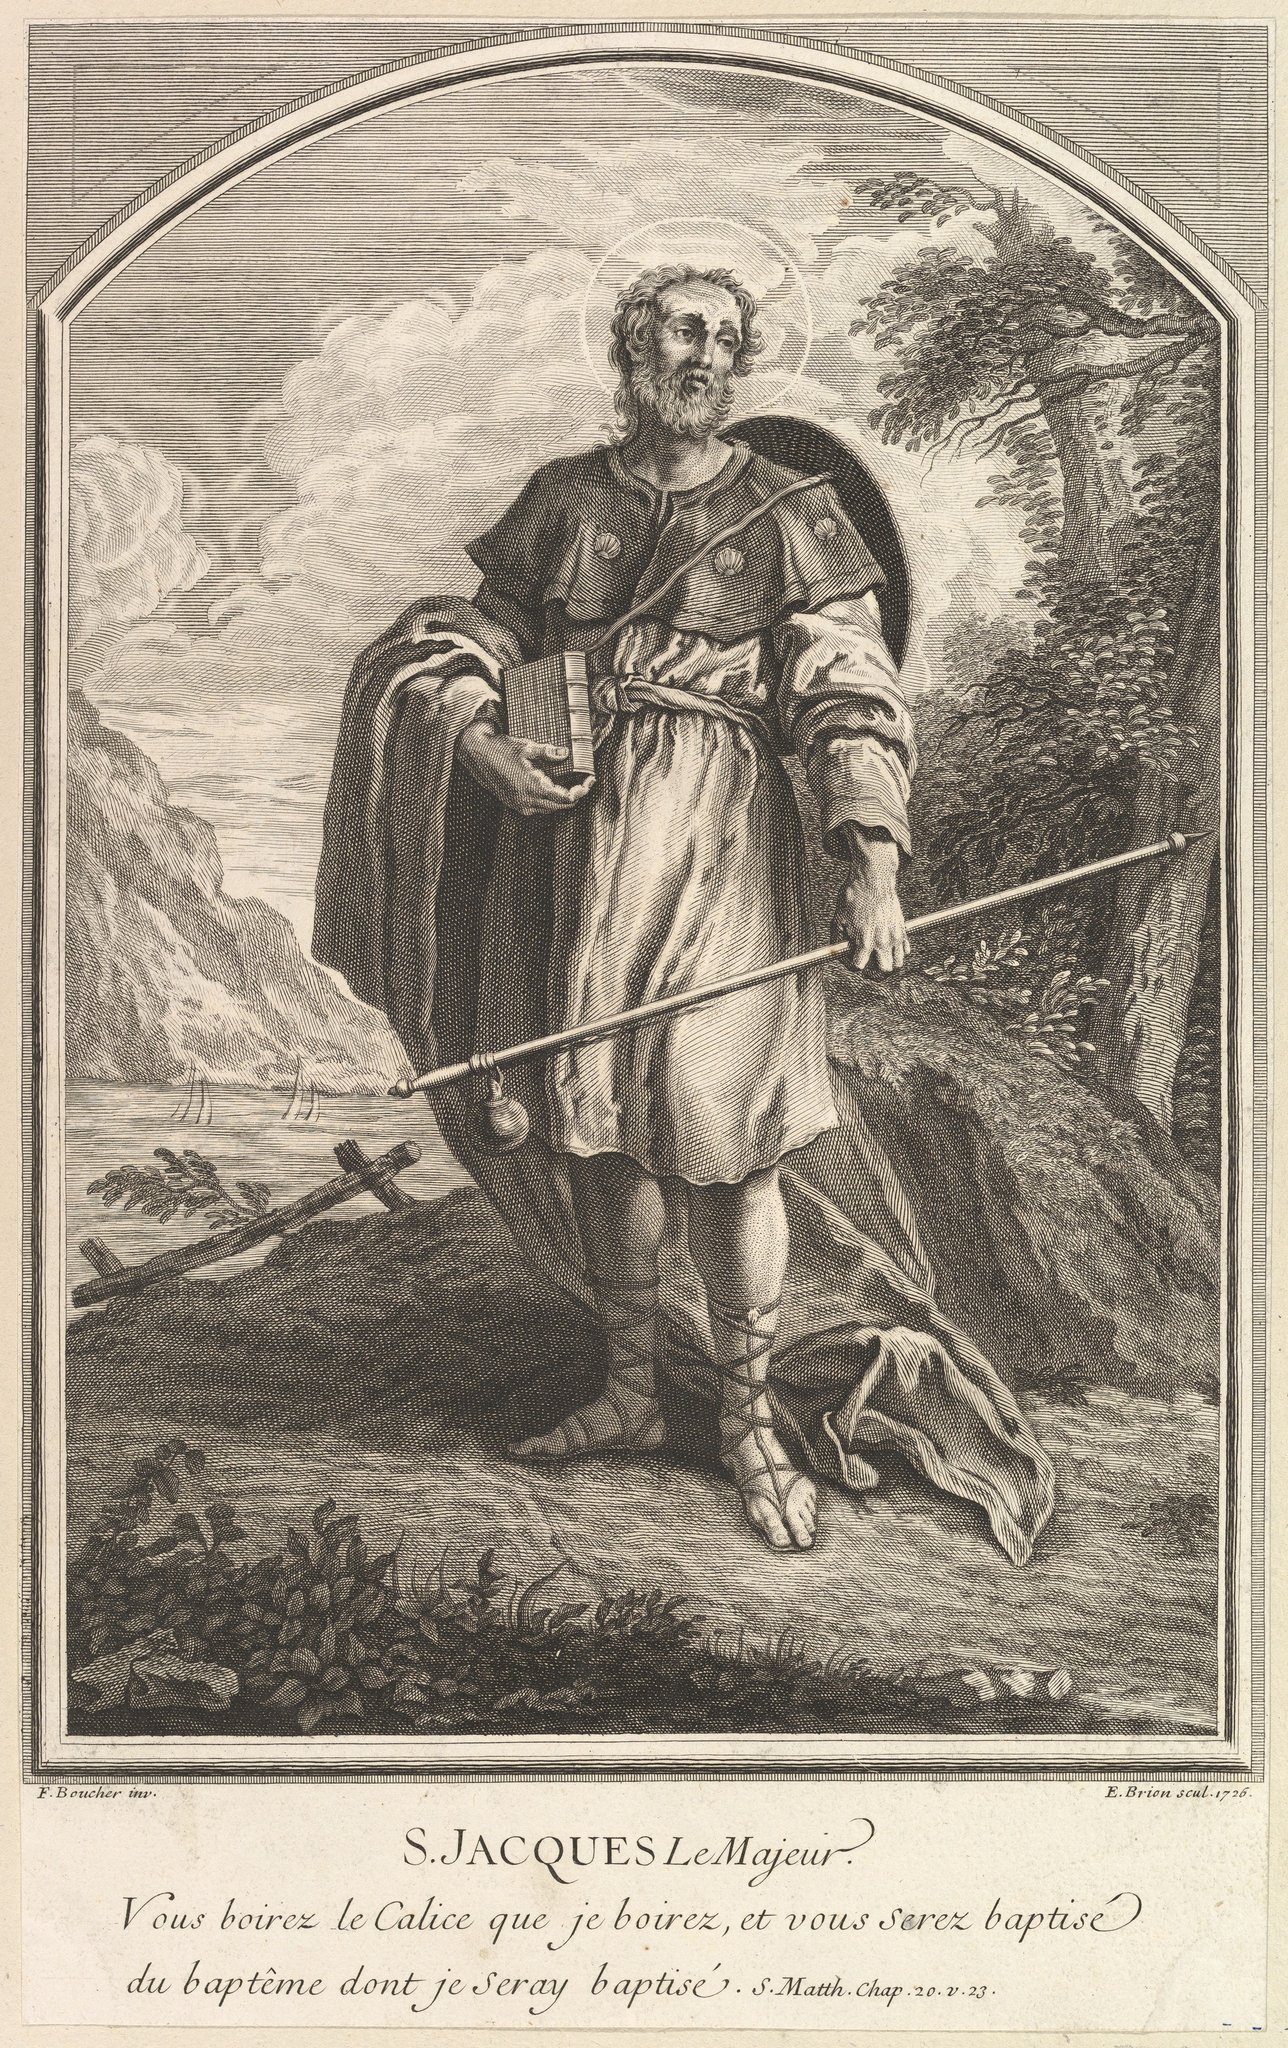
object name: print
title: Saint Jacques Le Majeur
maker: etienne brion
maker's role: artist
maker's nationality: french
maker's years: 1700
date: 1726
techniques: engraving, etching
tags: men,saints